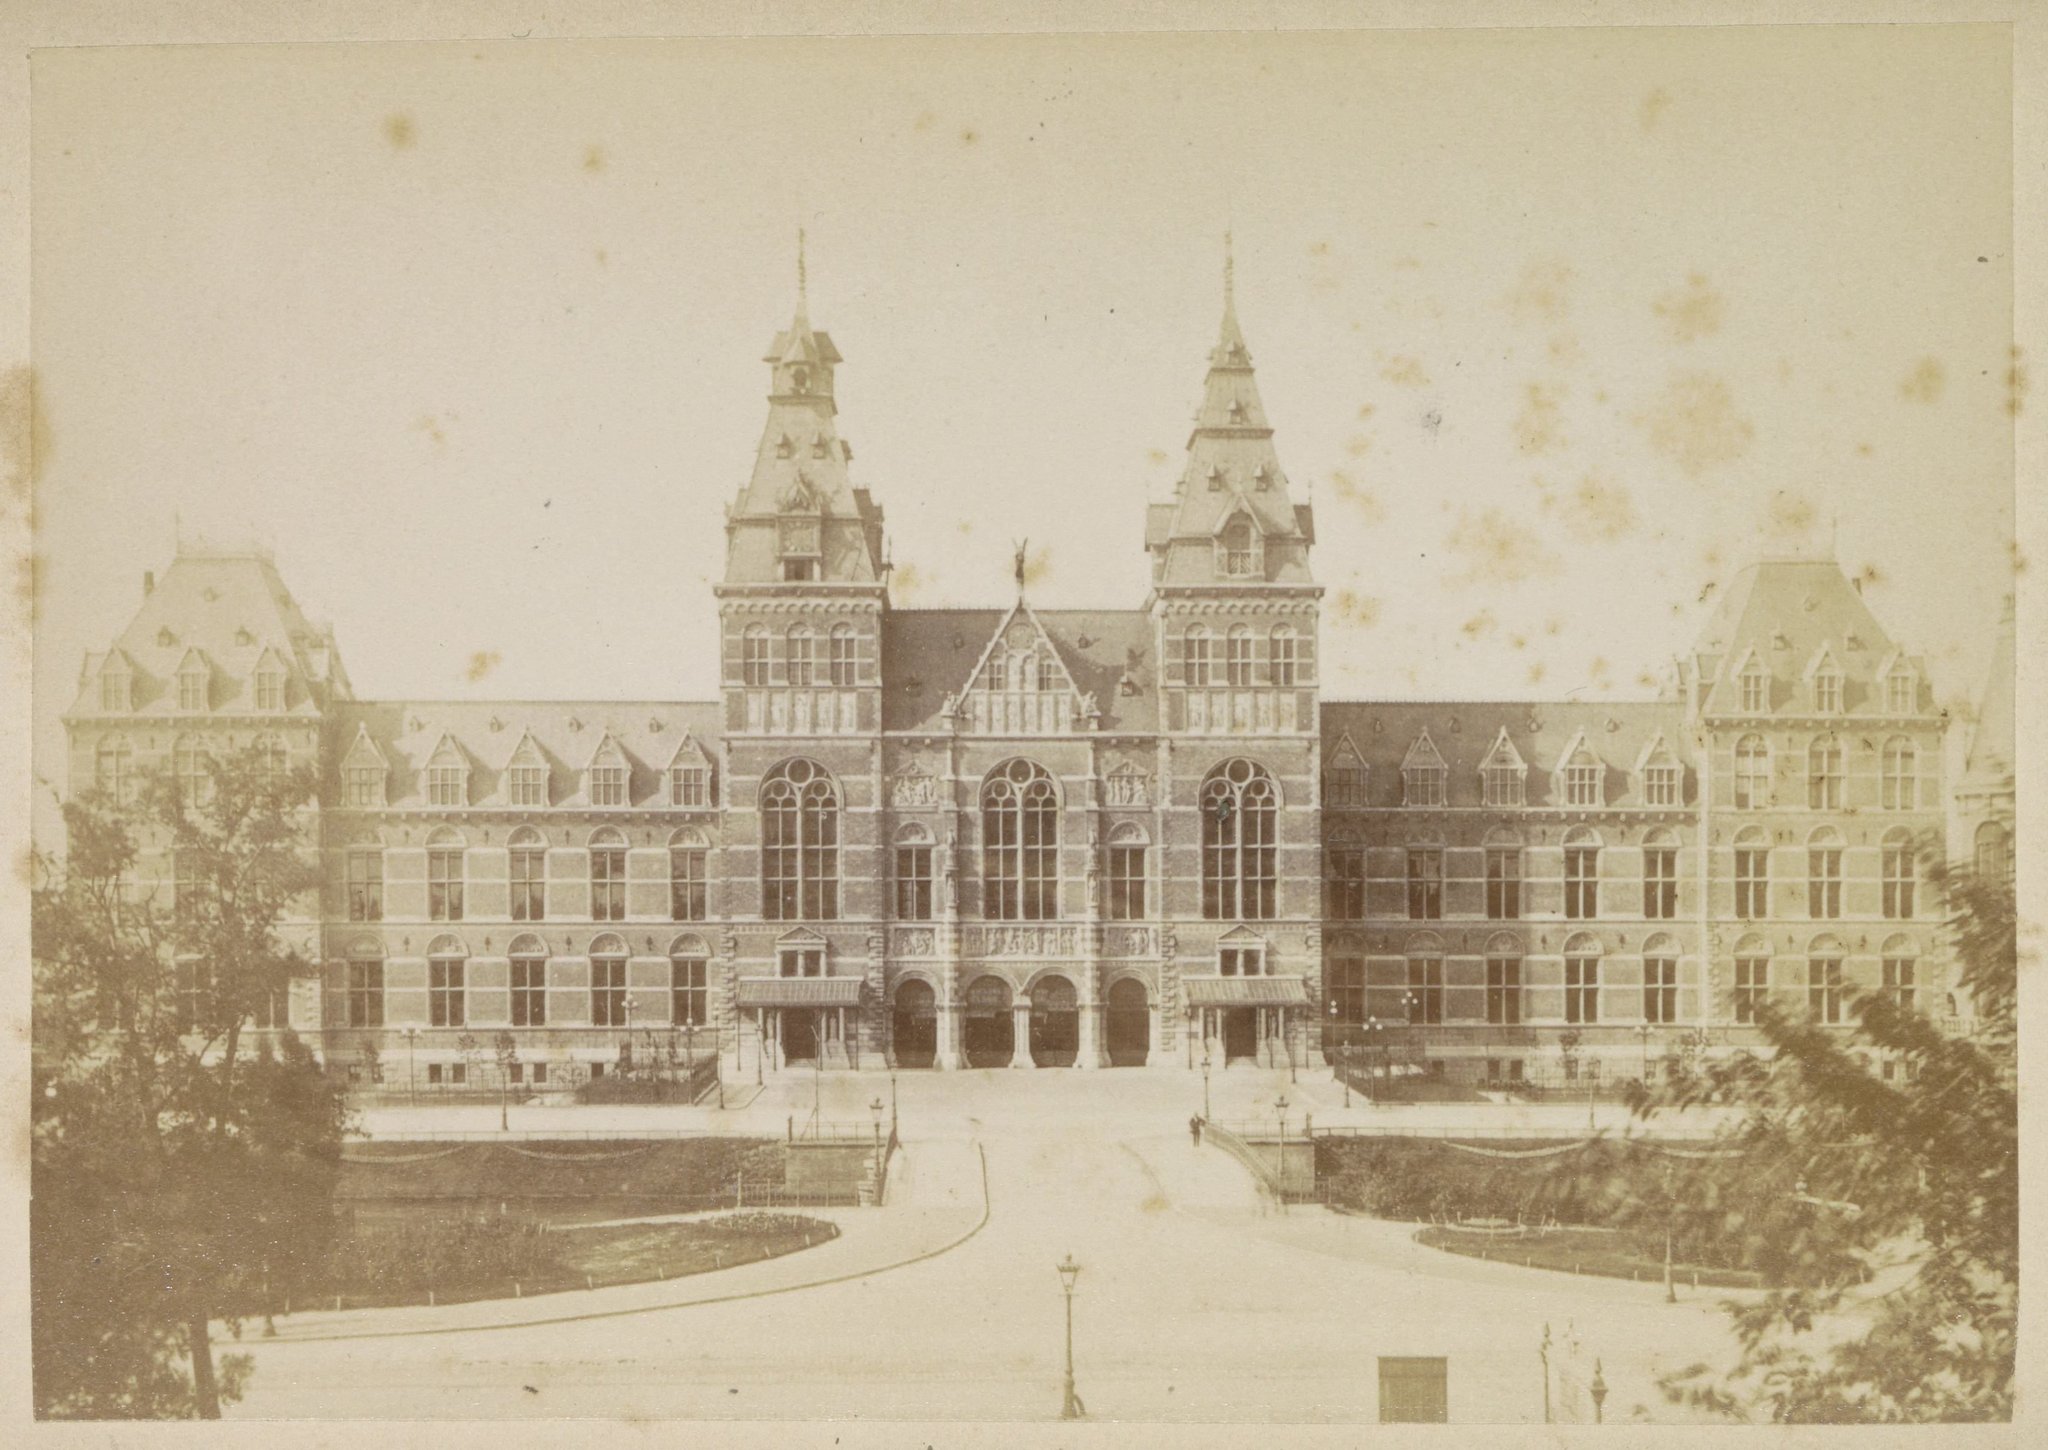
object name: photograph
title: Gezicht op de noordgevel van het Rijksmuseum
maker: andries jager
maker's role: publisher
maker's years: 1825-1905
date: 1885-1900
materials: cardboard, photographic support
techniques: albumen print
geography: amsterdam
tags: permanent exhibition, museum, façade (of house or building)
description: Onderdeel van Leporelloalbum met 24 foto's van Amsterdam.